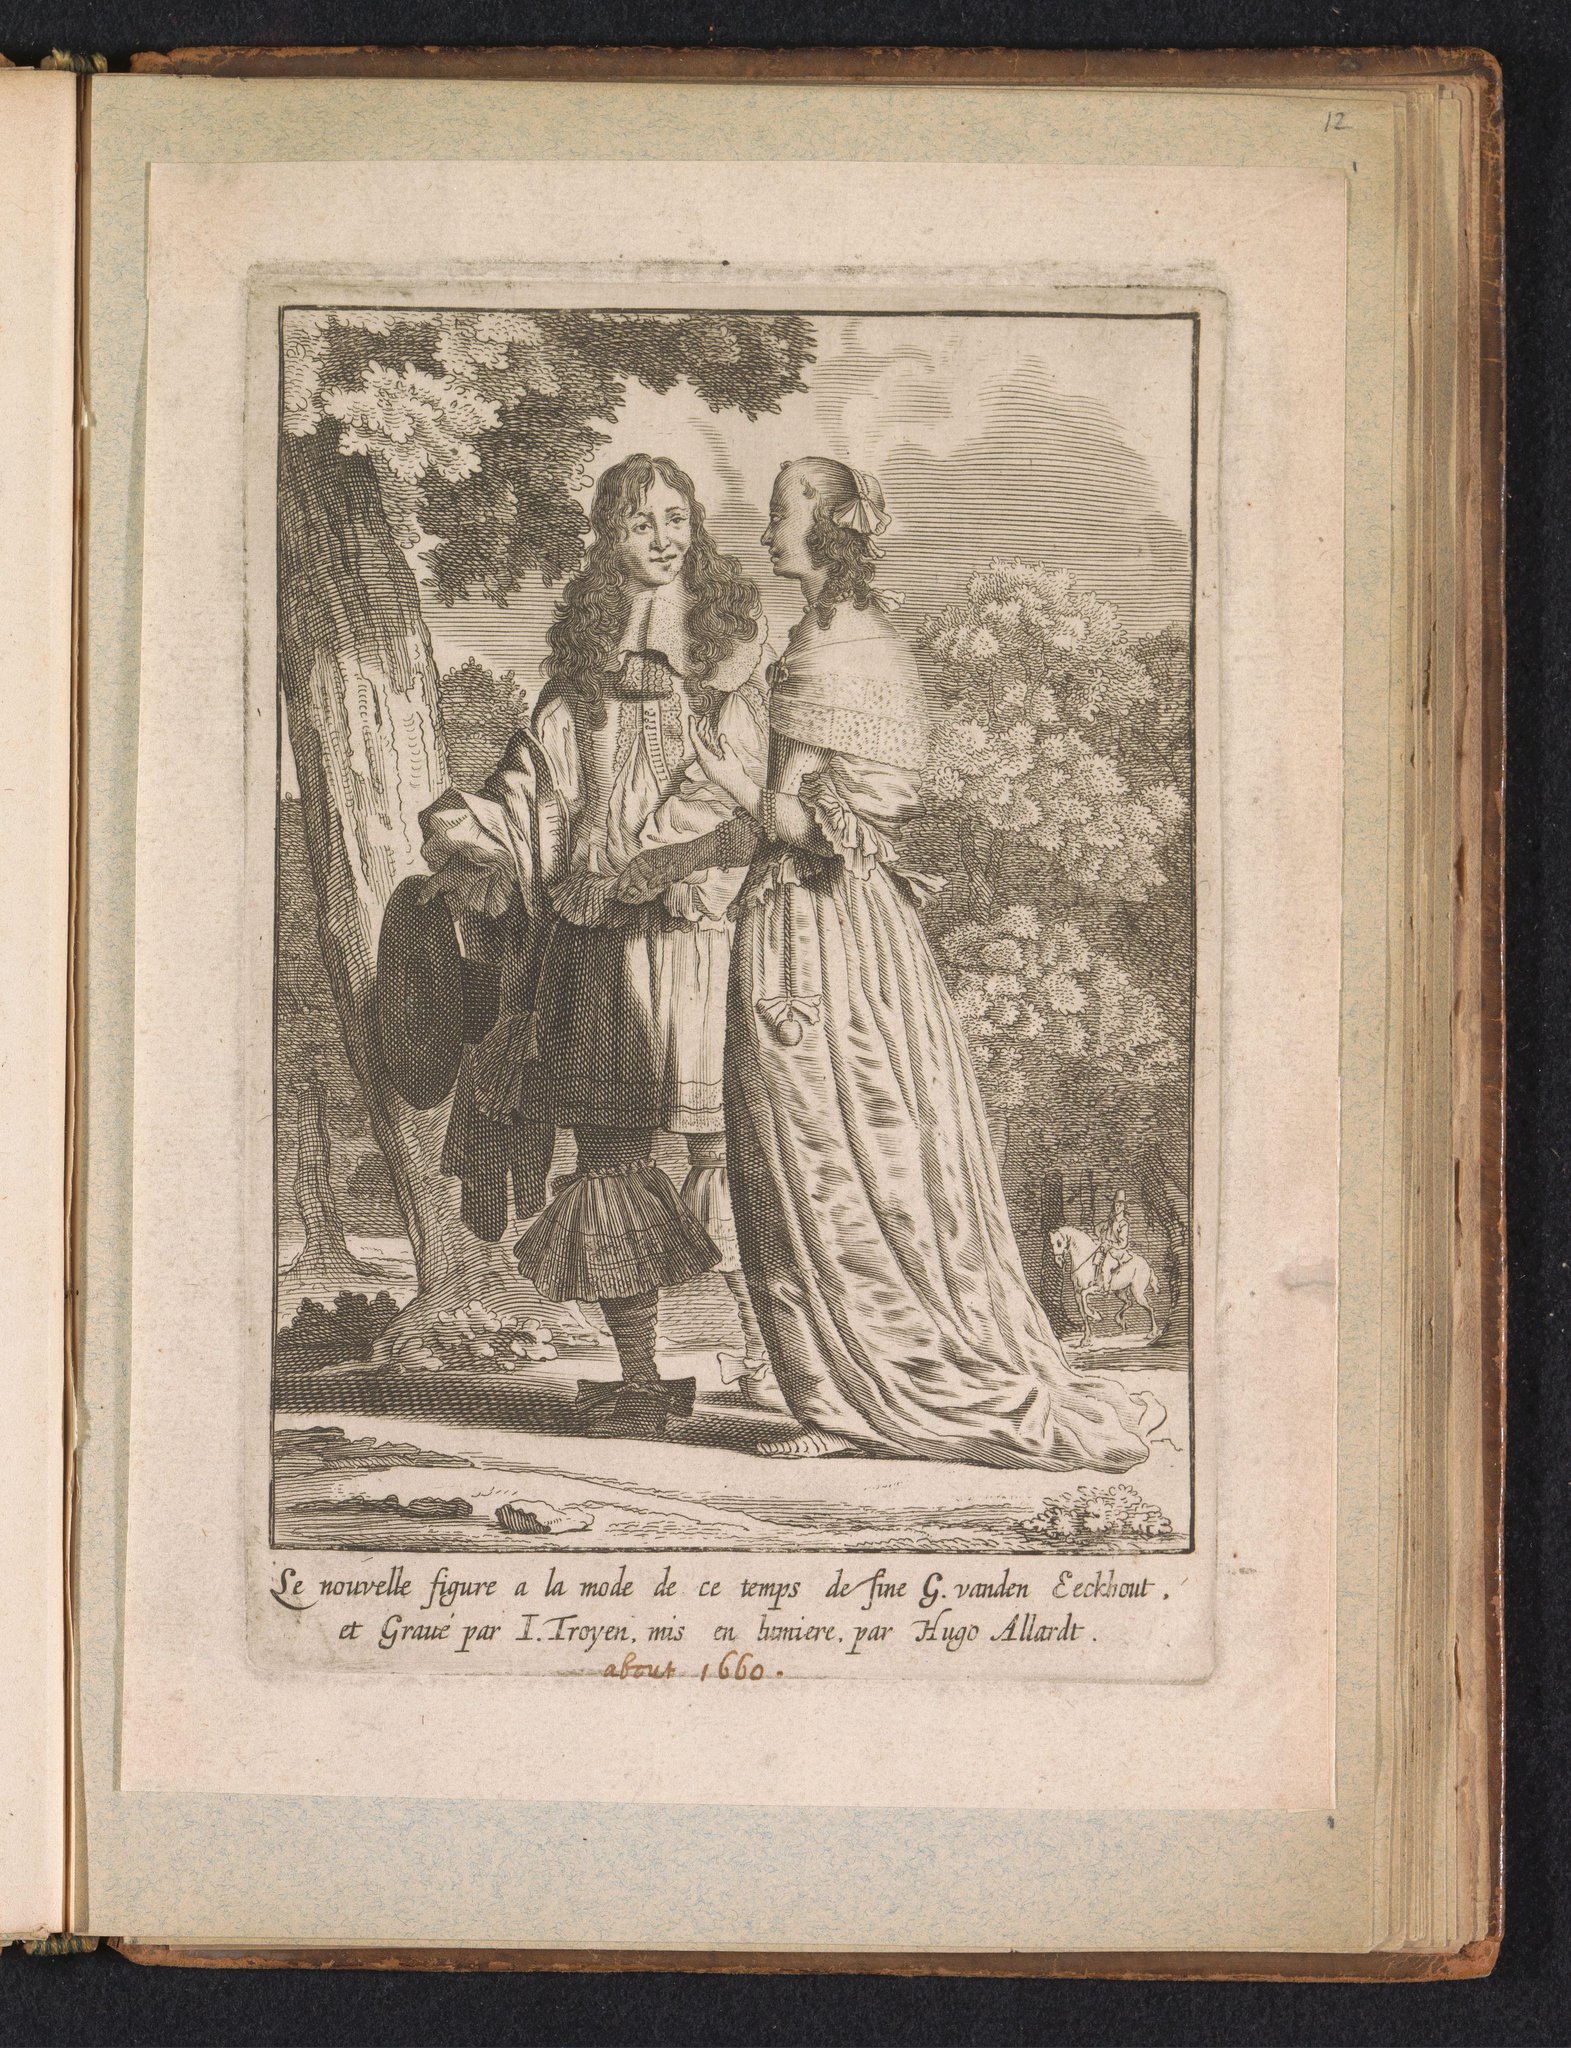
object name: costume print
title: Le nouvelle figure a la mode de ce temps.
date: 1660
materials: paper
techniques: engraving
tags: coat (+ men's clothes), neck-gear ~ clothing (cape collar) (+ women's clothes), fashion plates, clothes, costume (+ women's clothes), dress, gown (+ women's clothes), shoes, sandals (+ men's clothes), clothes, costume (+ men's clothes), care of the hair, neck-gear: collar (+ men's clothes), clothing for the upper part of the body (doublet) (+ men's clothes), stockings, socks (+ men's clothes), trousers, breeches, etc. (petticoat breeches) (+ men's clothes), netherlands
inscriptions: address: ‘dessine G. vanden Eeckhout, et Gravé par I. Troyen, mis en lumiere par Hugo Allardt’, caption: ‘Le nouvelle figure a la mode de ce temps ...’, date: ‘about 1660’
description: Elegant geklede man en vrouw, hand in hand lopend in landschap, naar links. De dame is gekleed in japon met platte brede kanten kraag; armbanden om beide polsen, beursje aan ceintuur. De heer draagt kousen met zeer brede kanten lubben. Schoenen met strikken. Hoed in de rechterhand. Met onderschrift: Le nouvelle figure a la mode de ce temps..